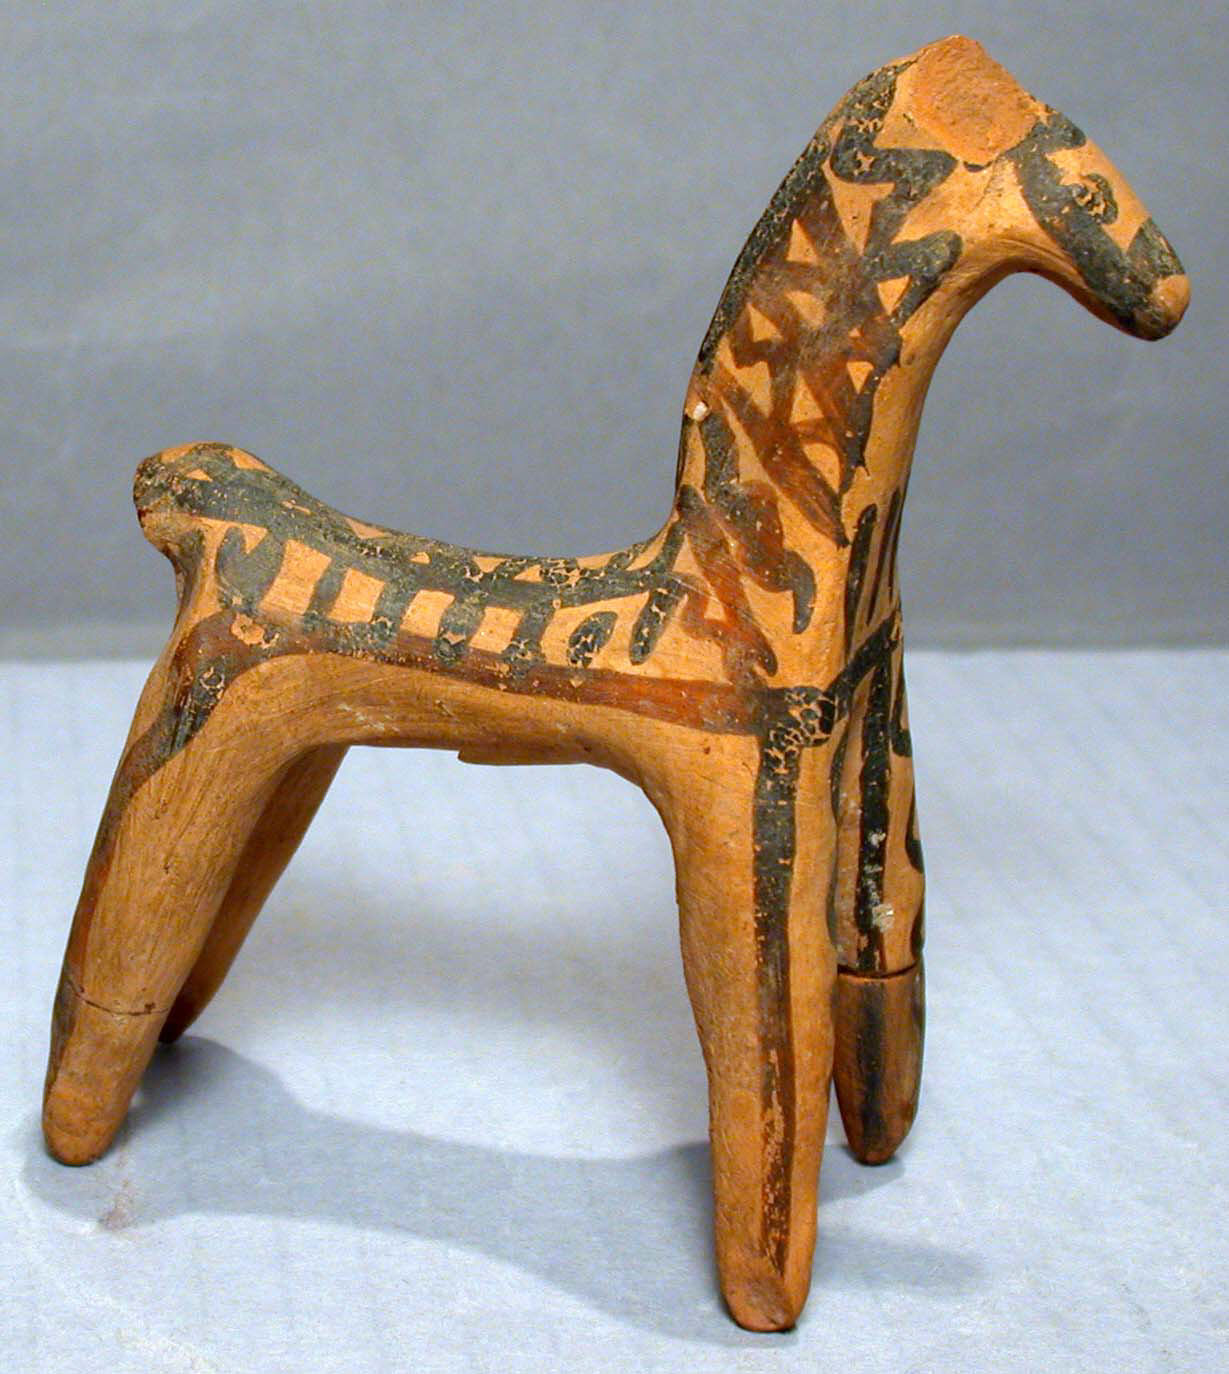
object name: statuette of a horse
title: Terracotta statuette of a horse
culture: cypriot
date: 800-768 BCE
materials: terracotta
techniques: painting